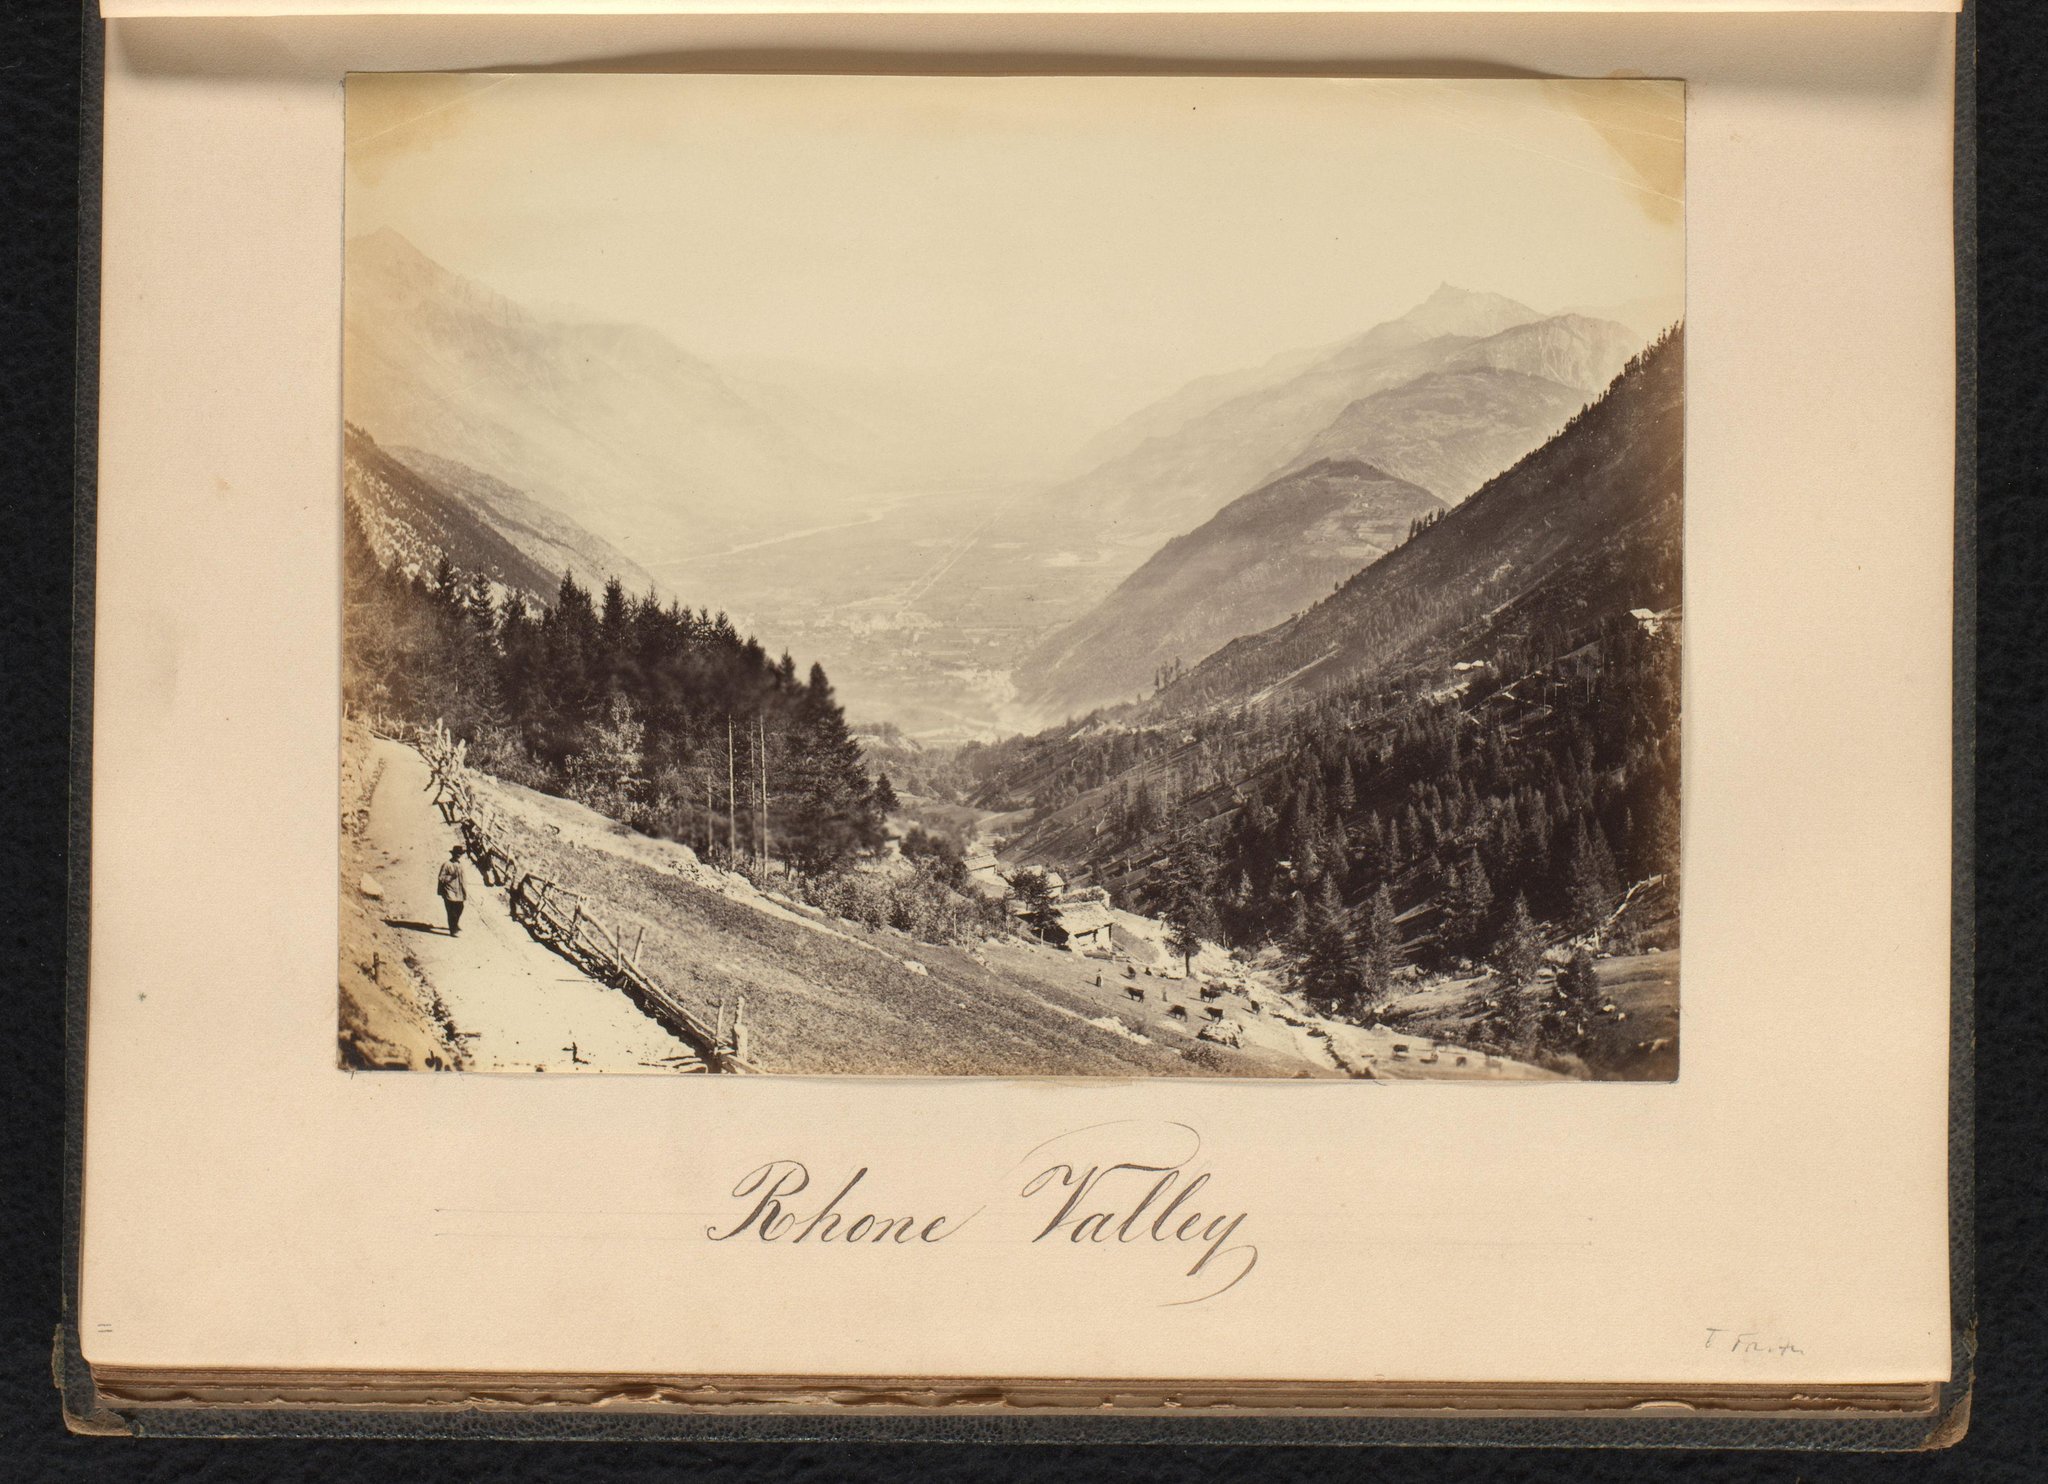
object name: album leaf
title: Rhone Valley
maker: francis frith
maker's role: publisher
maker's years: 1822-1898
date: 1860-1870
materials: paper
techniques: albumen print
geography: wallis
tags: dale, valley, mountains